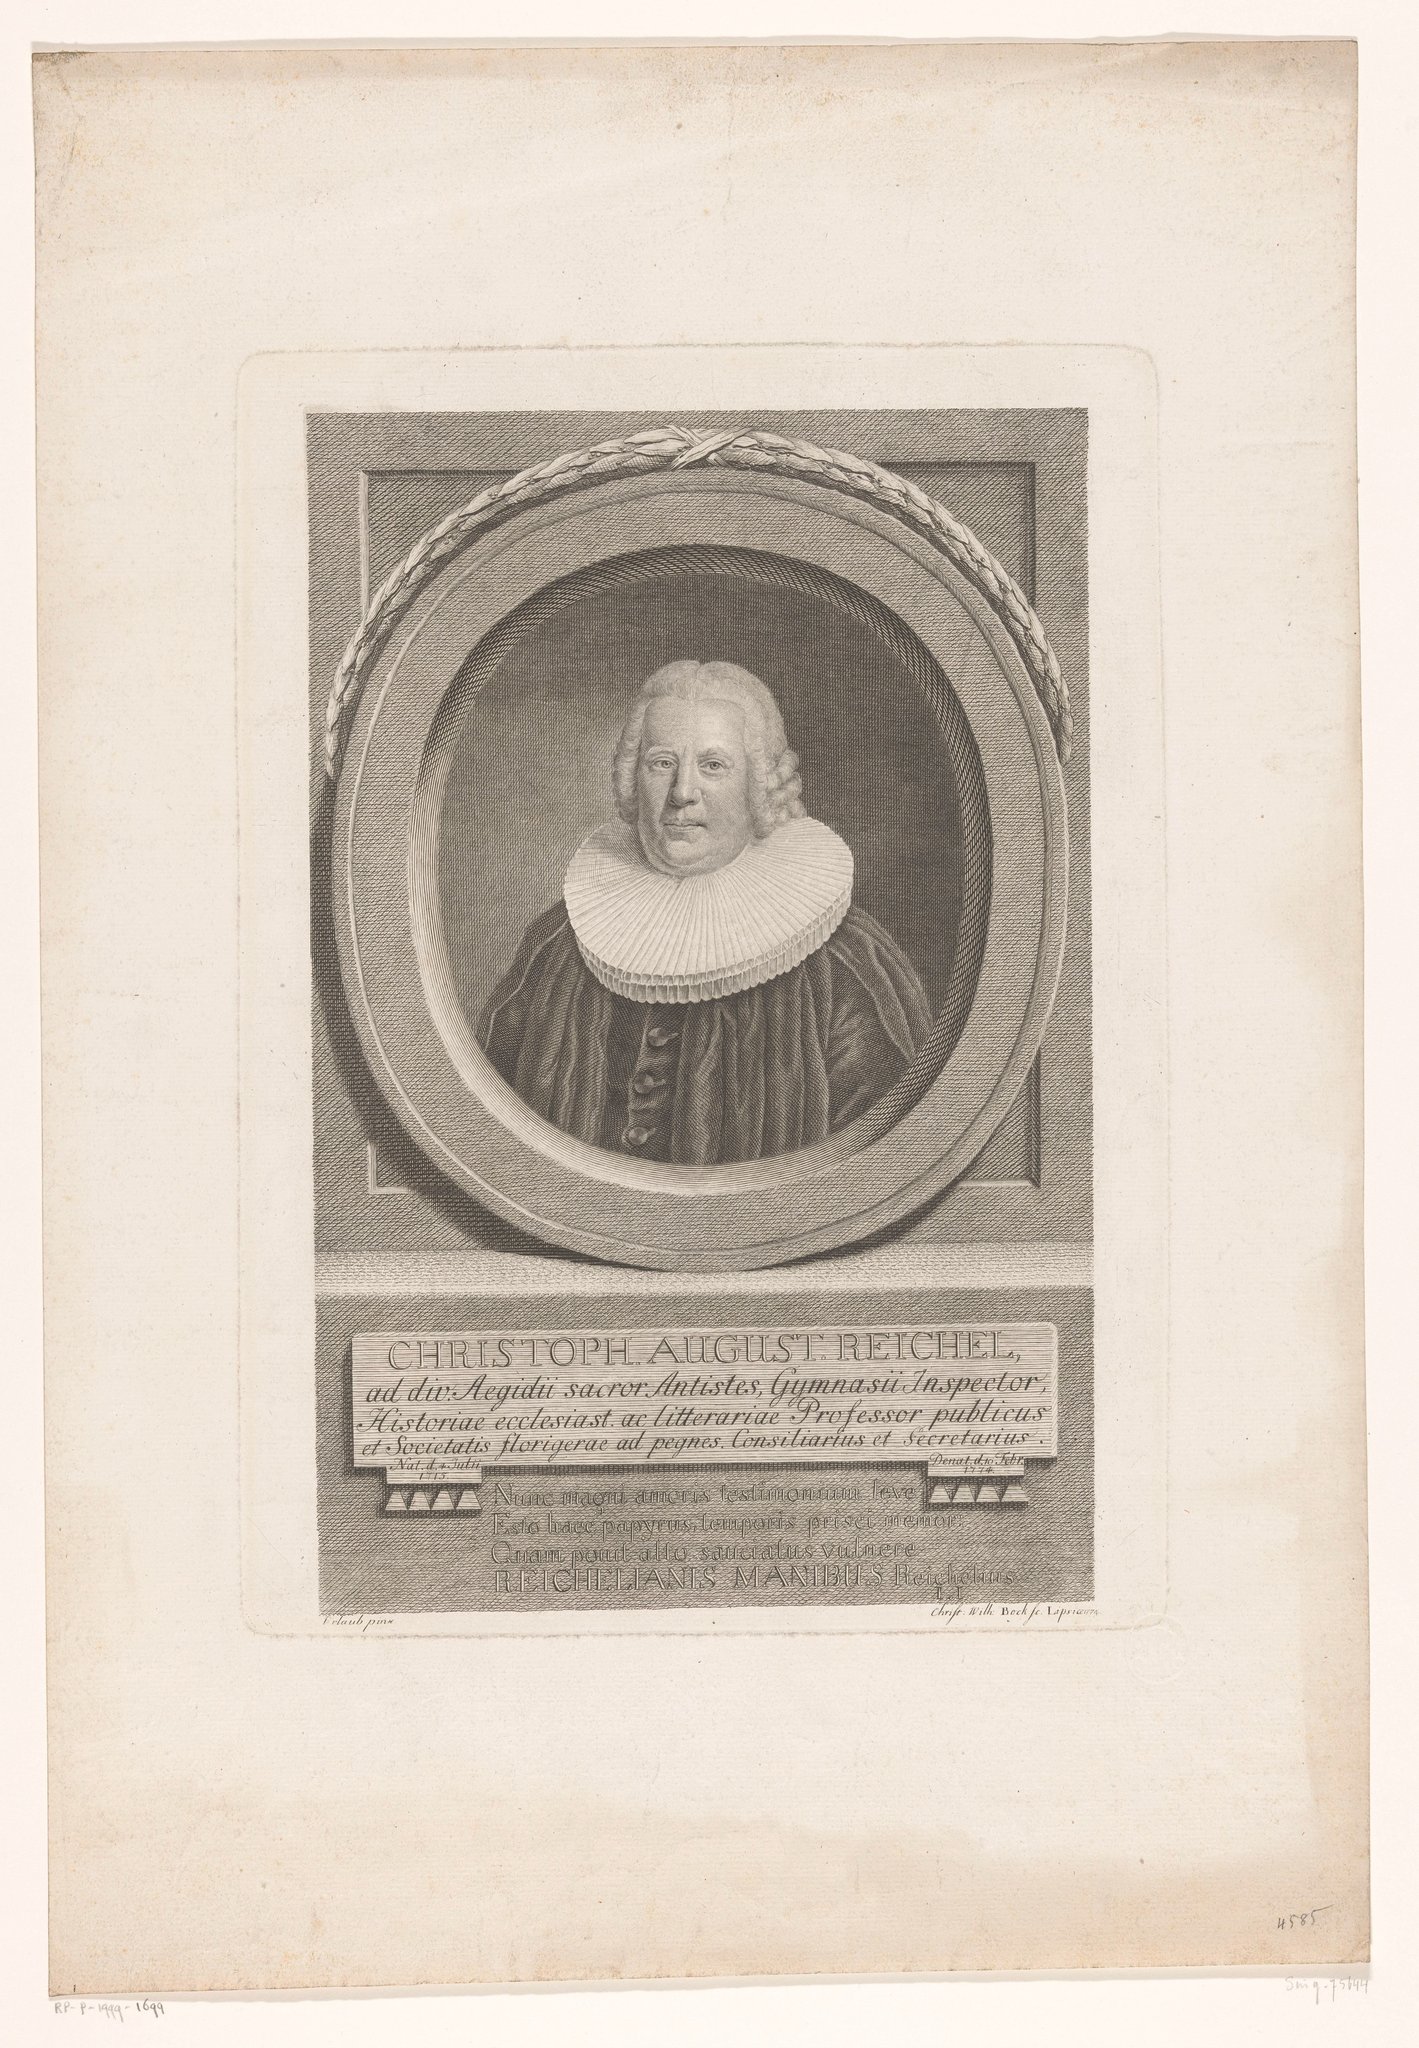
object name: print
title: Portret van Christoph August Reichel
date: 1774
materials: paper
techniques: engraving, etching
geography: leipzig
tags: christoph august reichel, historical persons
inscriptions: collector's mark: Lugt 2228, collector's mark: ‘JR of IR’